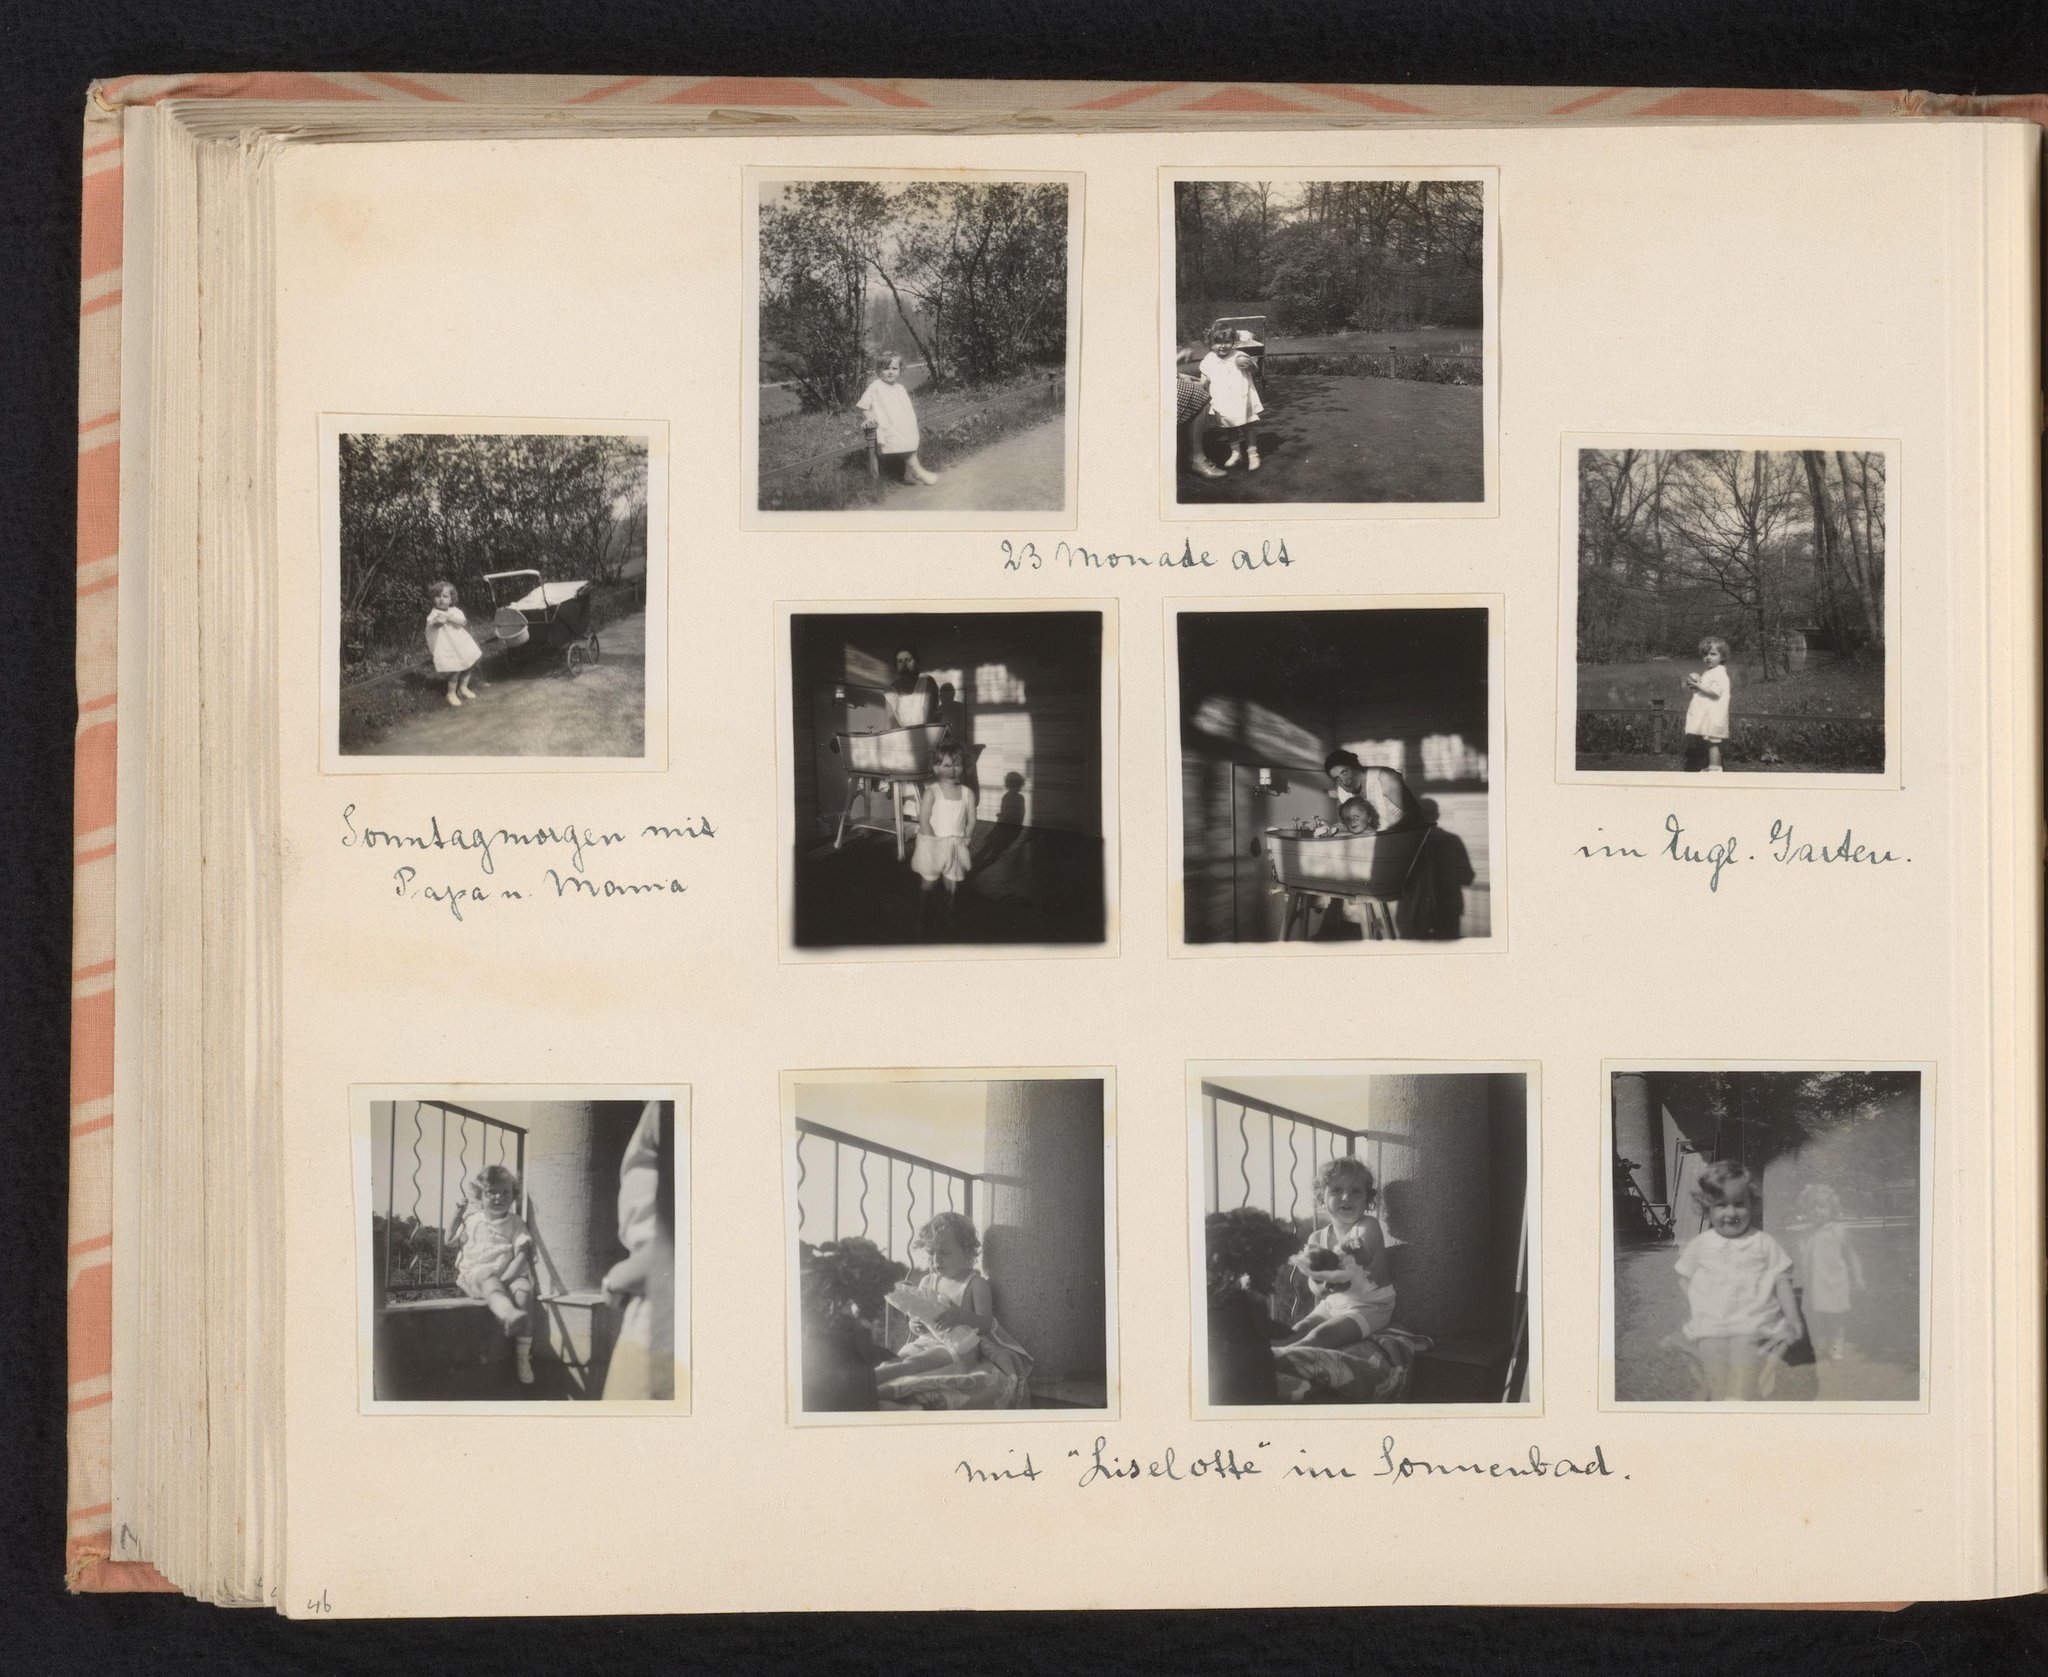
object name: album leaf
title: Isabel Wachenheimer en haar moeder Else Wachenheimer-Moos in de Engelse tuinen, in een badje en op het balkon, mei 1930, München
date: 1905-1930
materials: paper, photographic support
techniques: gelatin silver print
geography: munich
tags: else wachenheimer-moos, leiden, isabel wachenheimer-elon, family life at home, mother and baby or young child, infant, baby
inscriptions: inscription: ‘23 Monate alt//Sonntagmorgen mit Papa u. Mama//in Engl. Garten//mit "Liselotte" in Sonnenbad.’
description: Albumblad met tien foto's. Beide foto's midden, Isabel Wachenheimer en Else Wachenheimer-Moos; acht overige foto's, Isabel Wachenheimer. Onderdeel van het fotoalbum met foto's van Isabel Wachenheimer als kind (1928-1931).